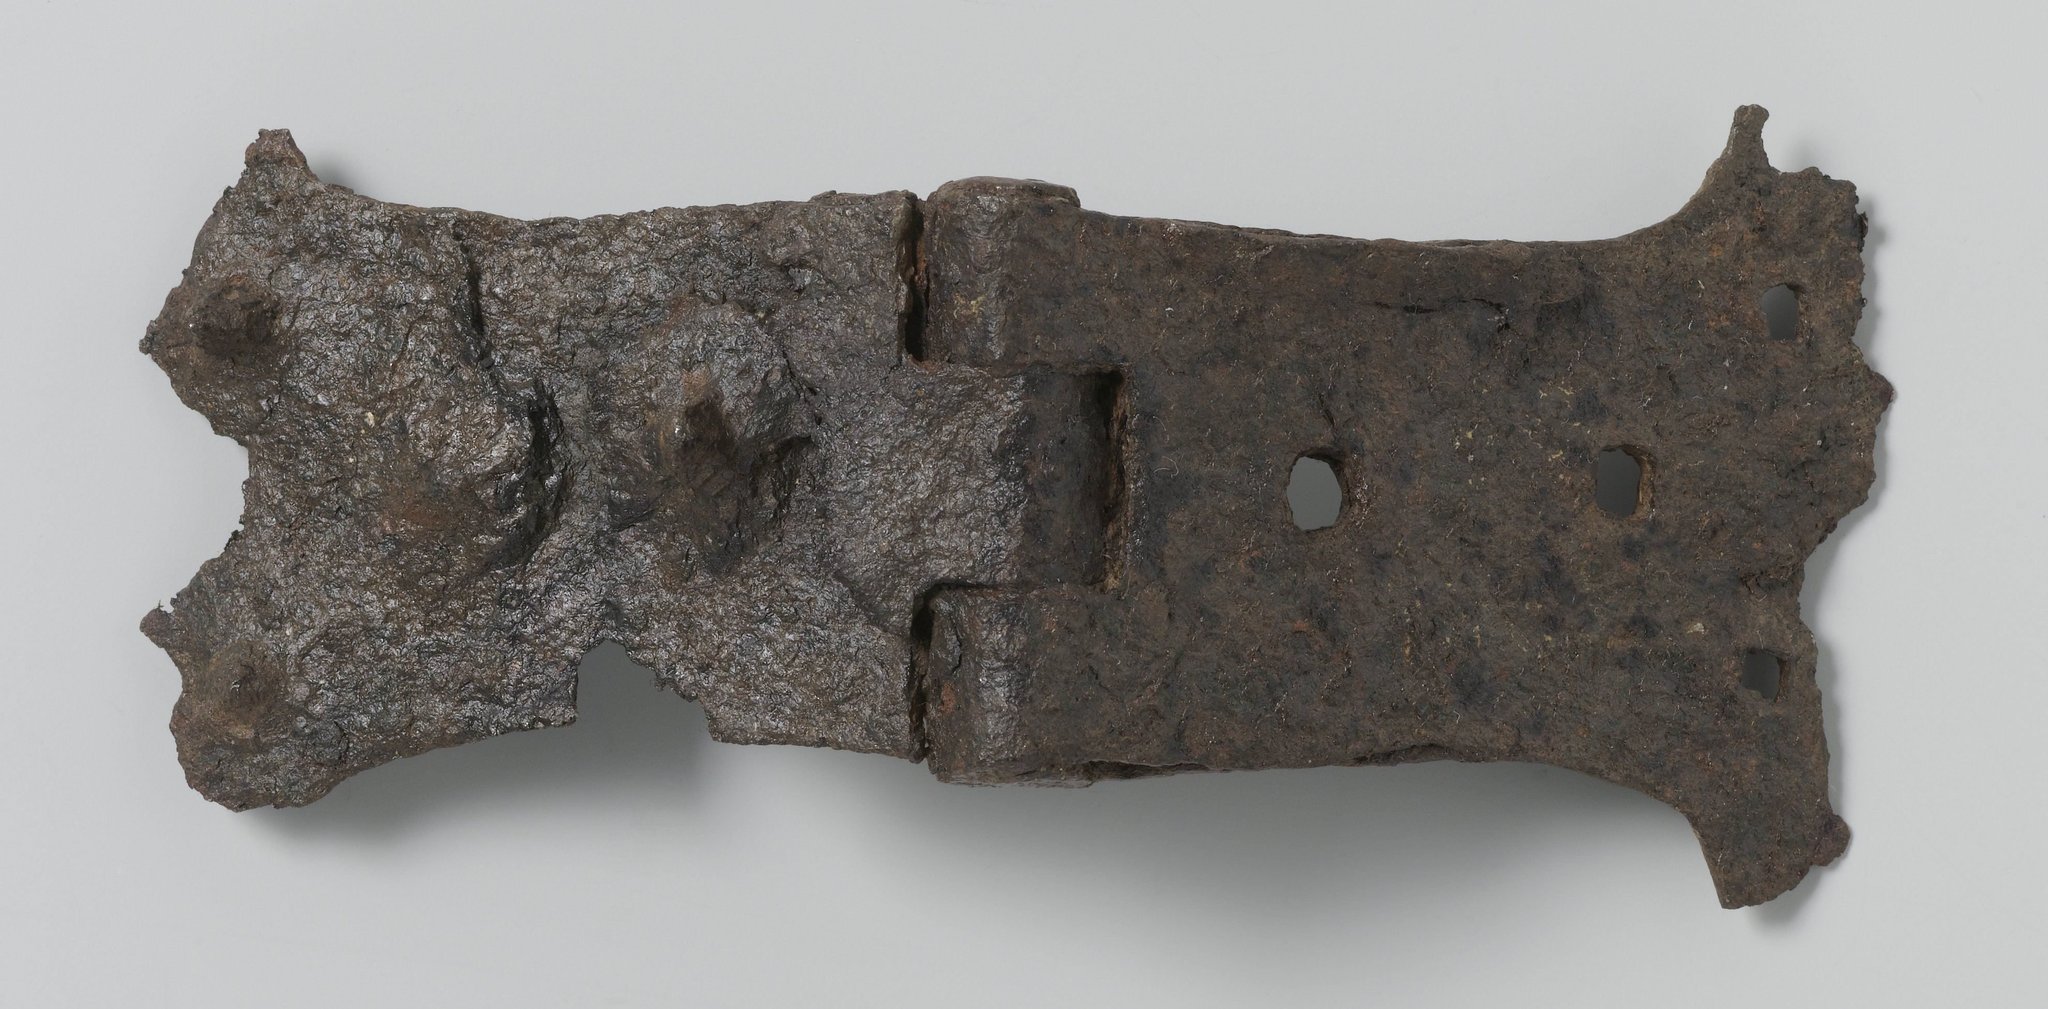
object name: scharnier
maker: Anonymous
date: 1590-1596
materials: iron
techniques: forging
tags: willem barendsz., amsterdam, jacob van heemskerck